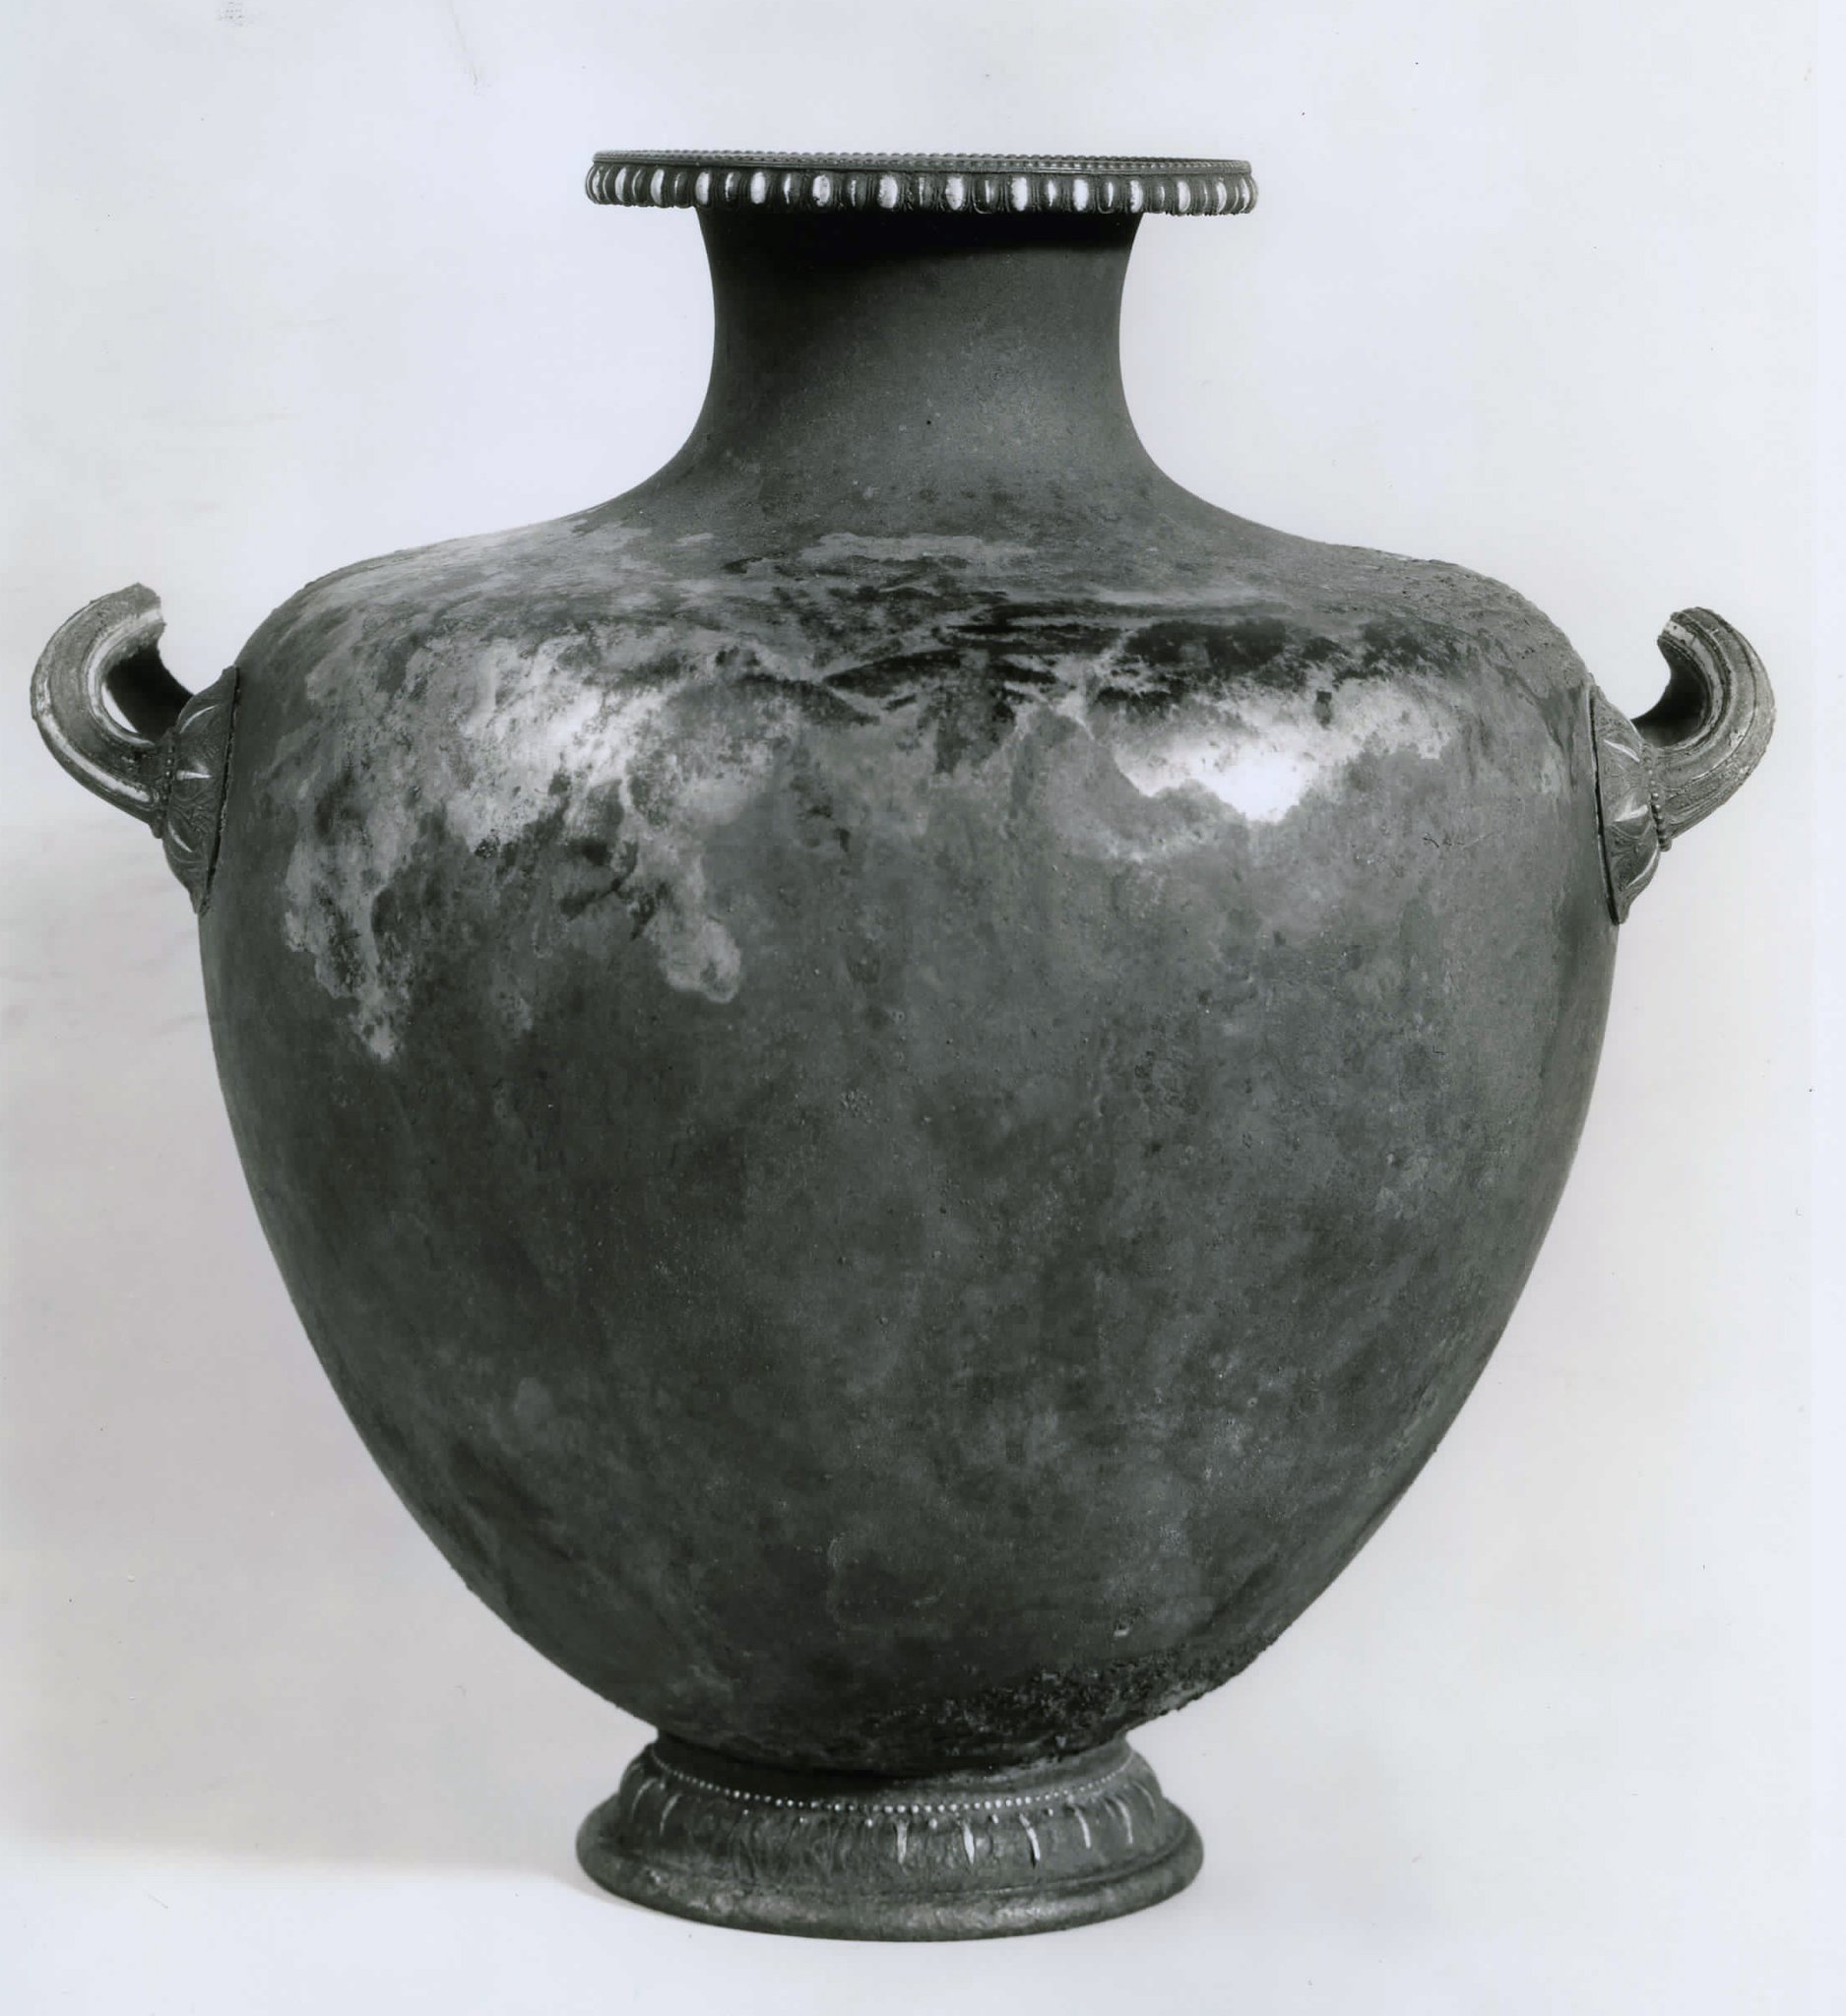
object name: hydria with silver inlay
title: Bronze hydria (water jar) with silver inlay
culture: greek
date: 434-401 BCE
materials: bronze, silver